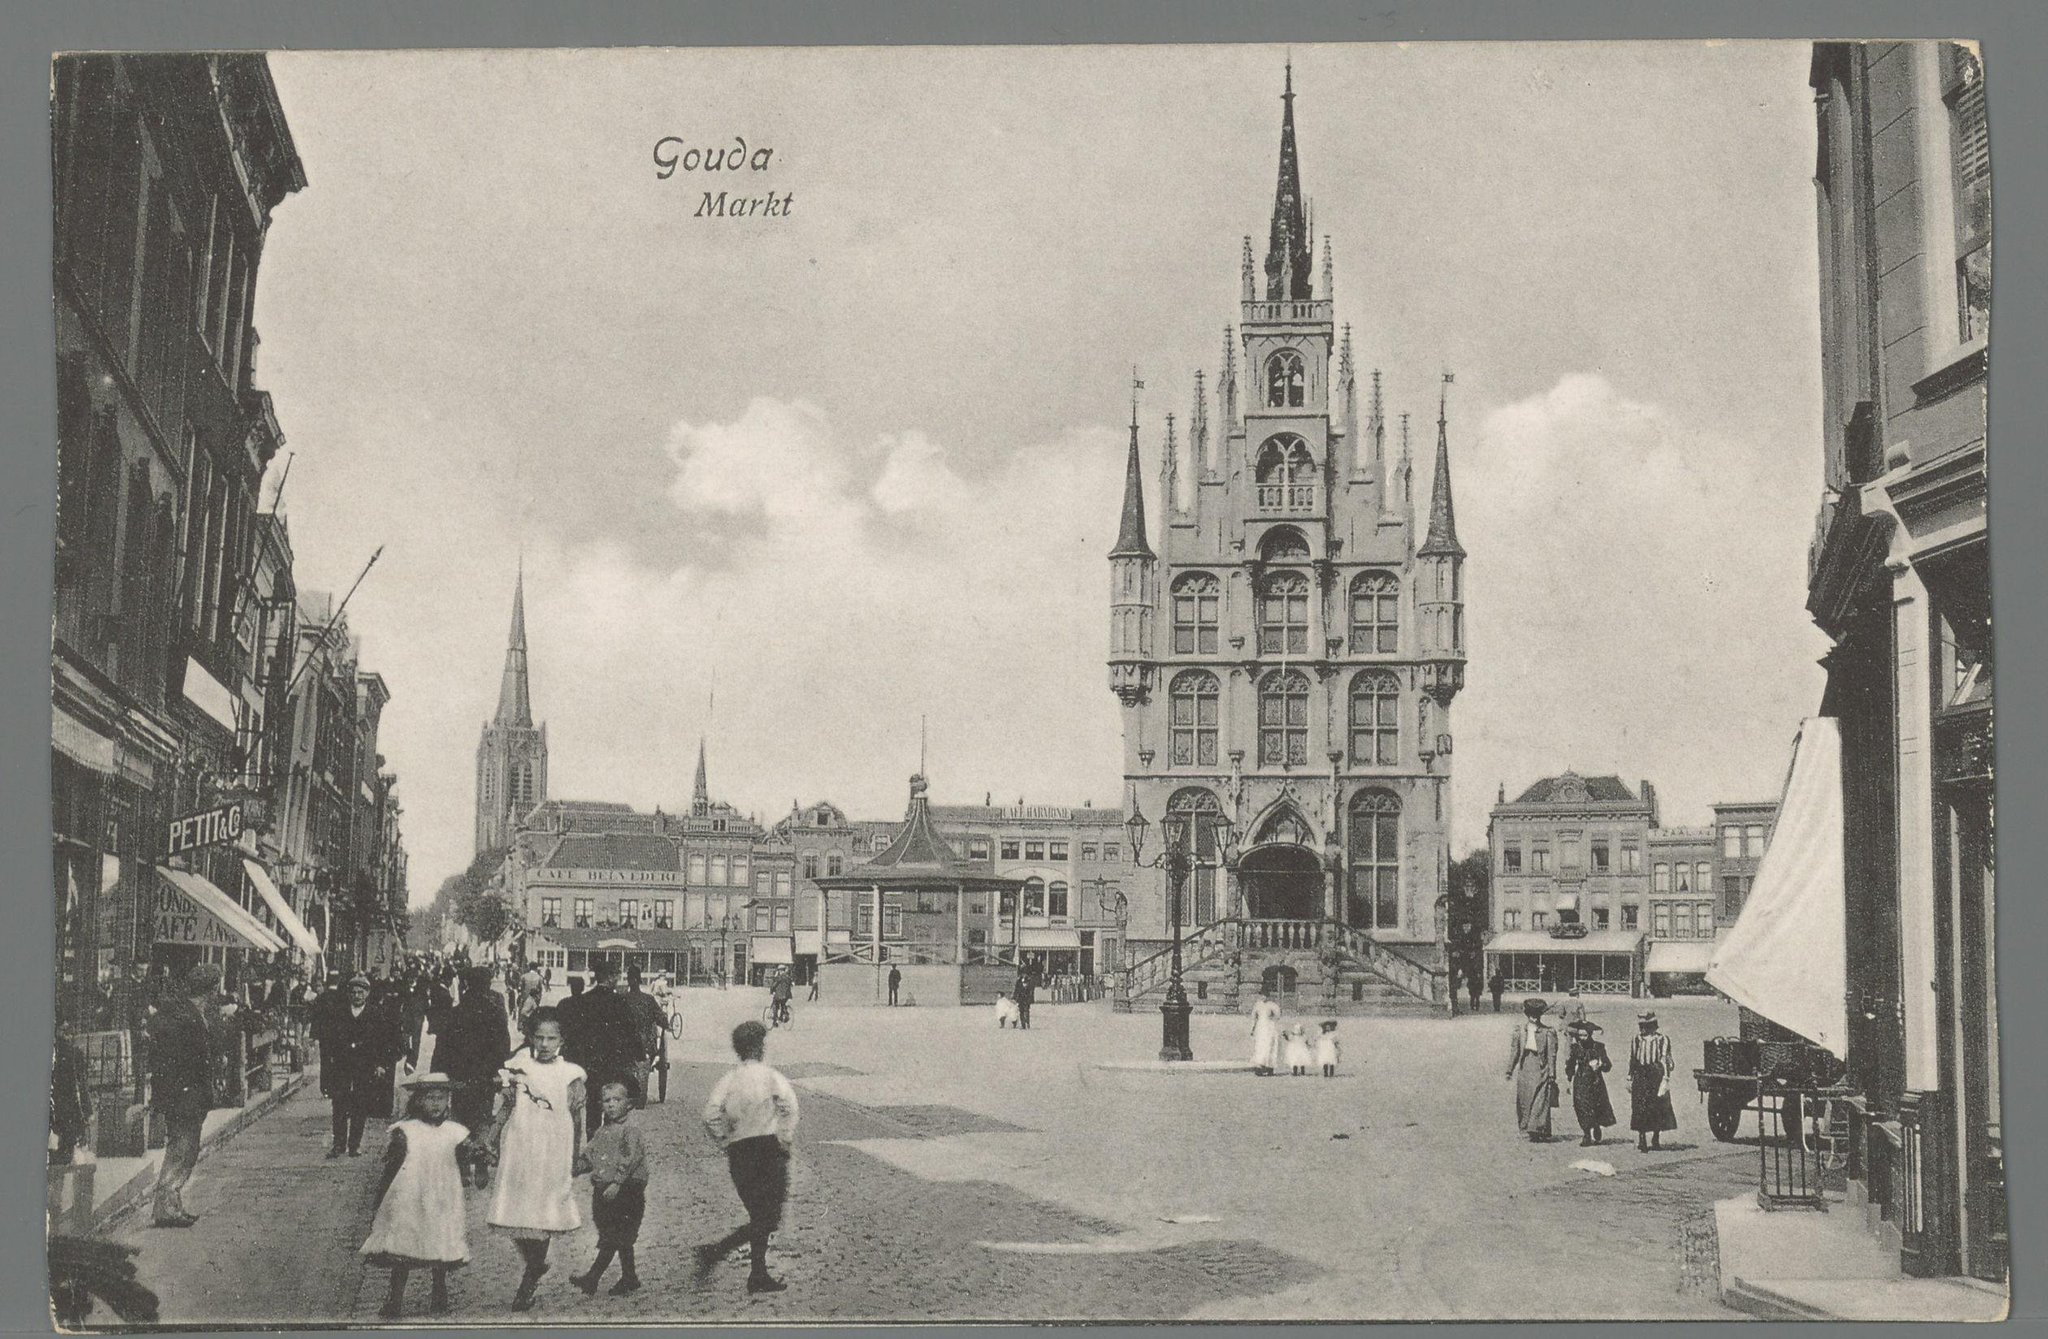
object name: photomechanical print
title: Gouda. Markt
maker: Anonymous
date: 1908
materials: cardboard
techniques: photograph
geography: gouda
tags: square, place, circus, etc., church (exterior), townhall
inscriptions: date